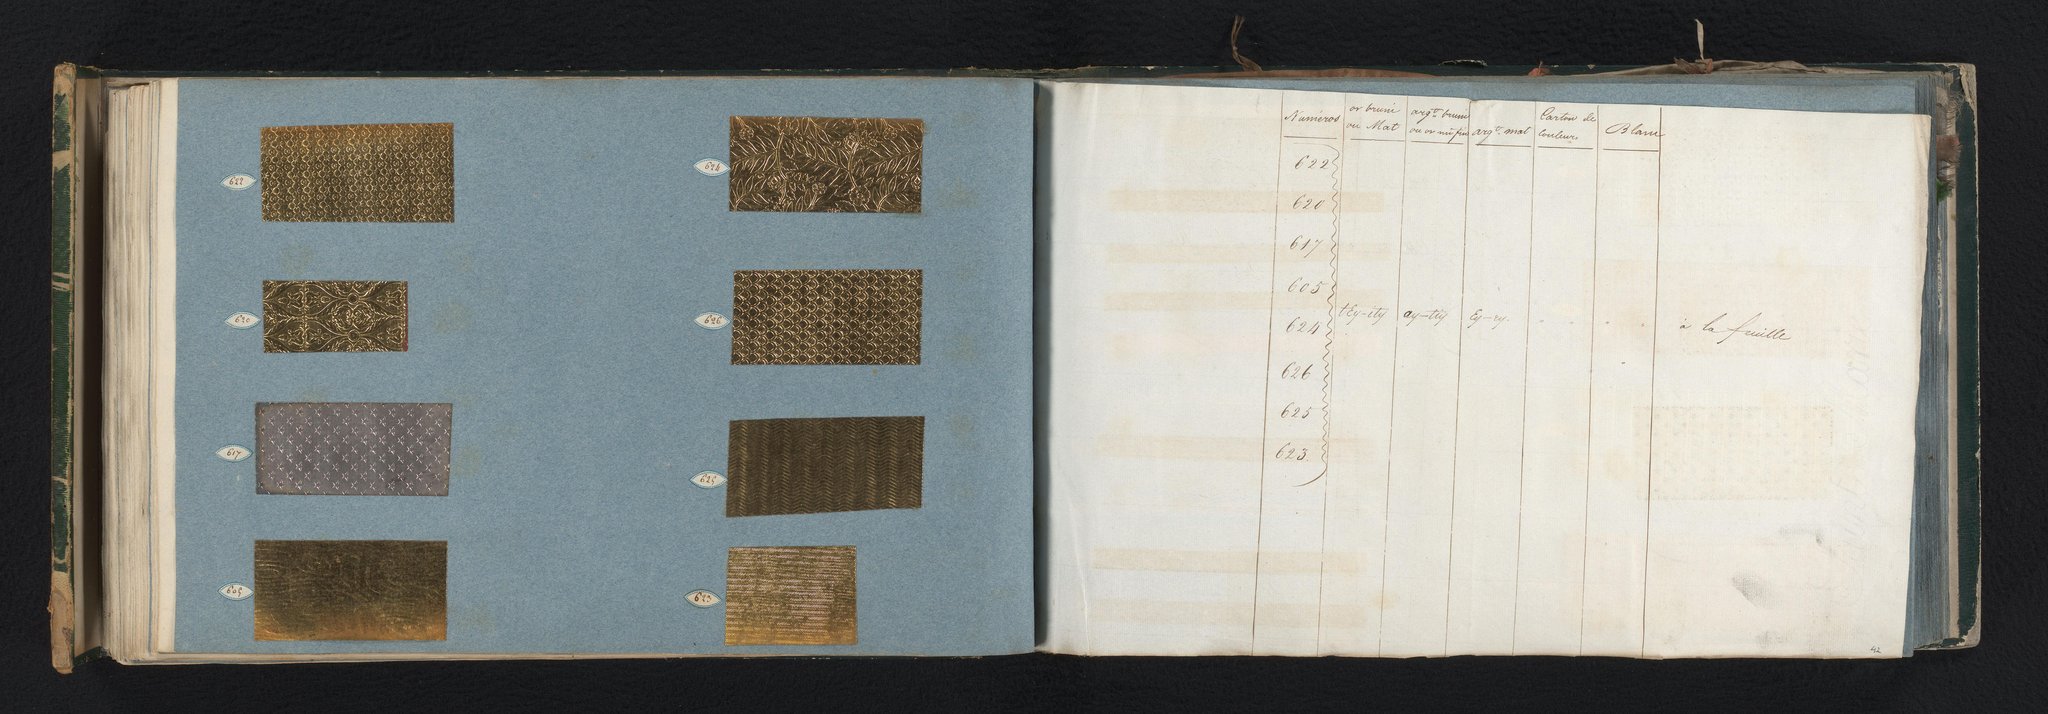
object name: album leaf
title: Twee bladzijden met stalen van goud- en zilverkleurig metaalpapier en bijbehorend tabel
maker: Anonymous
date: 1830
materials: gold leaf, ink, paper, silver leaf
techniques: writing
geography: france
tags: ornaments ~ art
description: Twee bladzijden met links 8 opgeplakte en met etiketten genummerde (622-623) stalen van gedecoreerd goud- en zilverkleurig metaalpapier. Op de tegenoverliggende rechterbladzijde een tabel met de handgeschreven corresponderende specificaties (in code) per ornament. Onderdeel van het stalenboek geschonken door de dames Van Rijn, vermoedelijk van een Franse papierfabrikant van luxe papieren, of diens vertegenwoordiger in Nederland, ca. 1830.